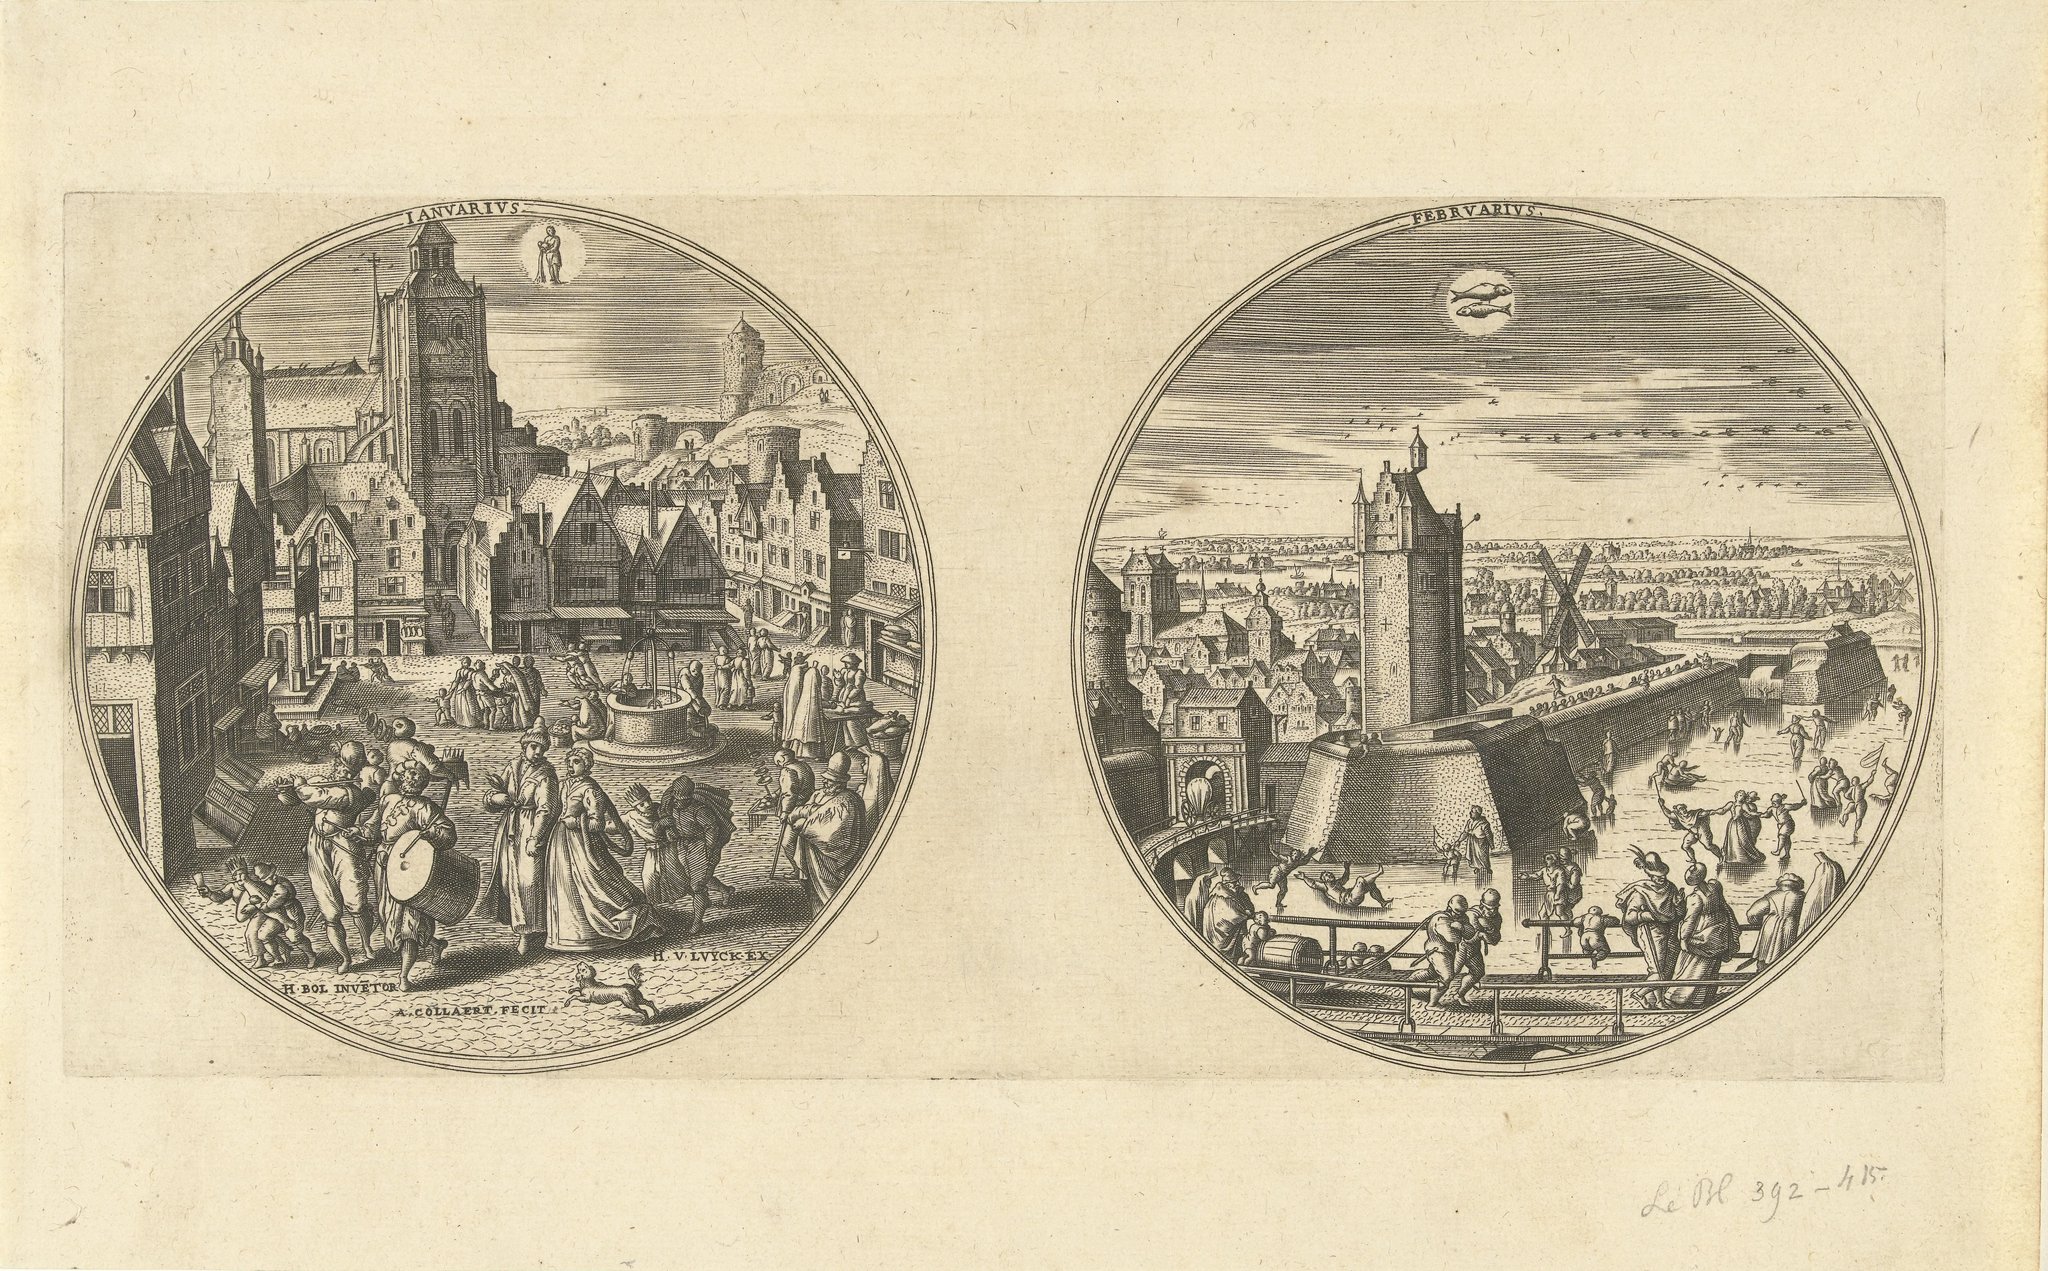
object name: print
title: Januari en februari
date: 1578-1582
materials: paper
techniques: engraving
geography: antwerp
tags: skates (winter sports), canals, waters (in city), epiphany, square, place, circus, etc. (+ city(-scape) with figures, staffage), january and its 'labours' (+ with zodiacal signs), february and its 'labours' (+ with zodiacal signs), bergen op zoom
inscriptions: collector's mark: Lugt 2228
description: Twee ronde lijsten met wintertaferelen in de stad. Links januari, de ijsmaand. Driekoningen wordt gevierd. Middenboven het sterrenbeeld Waterman. Rechts februari. Buiten een stad schaatsen mensen op de kanalen. Middenboven het sterrenbeeld vissen.De prent is deel van een serie over de twaalf maanden.